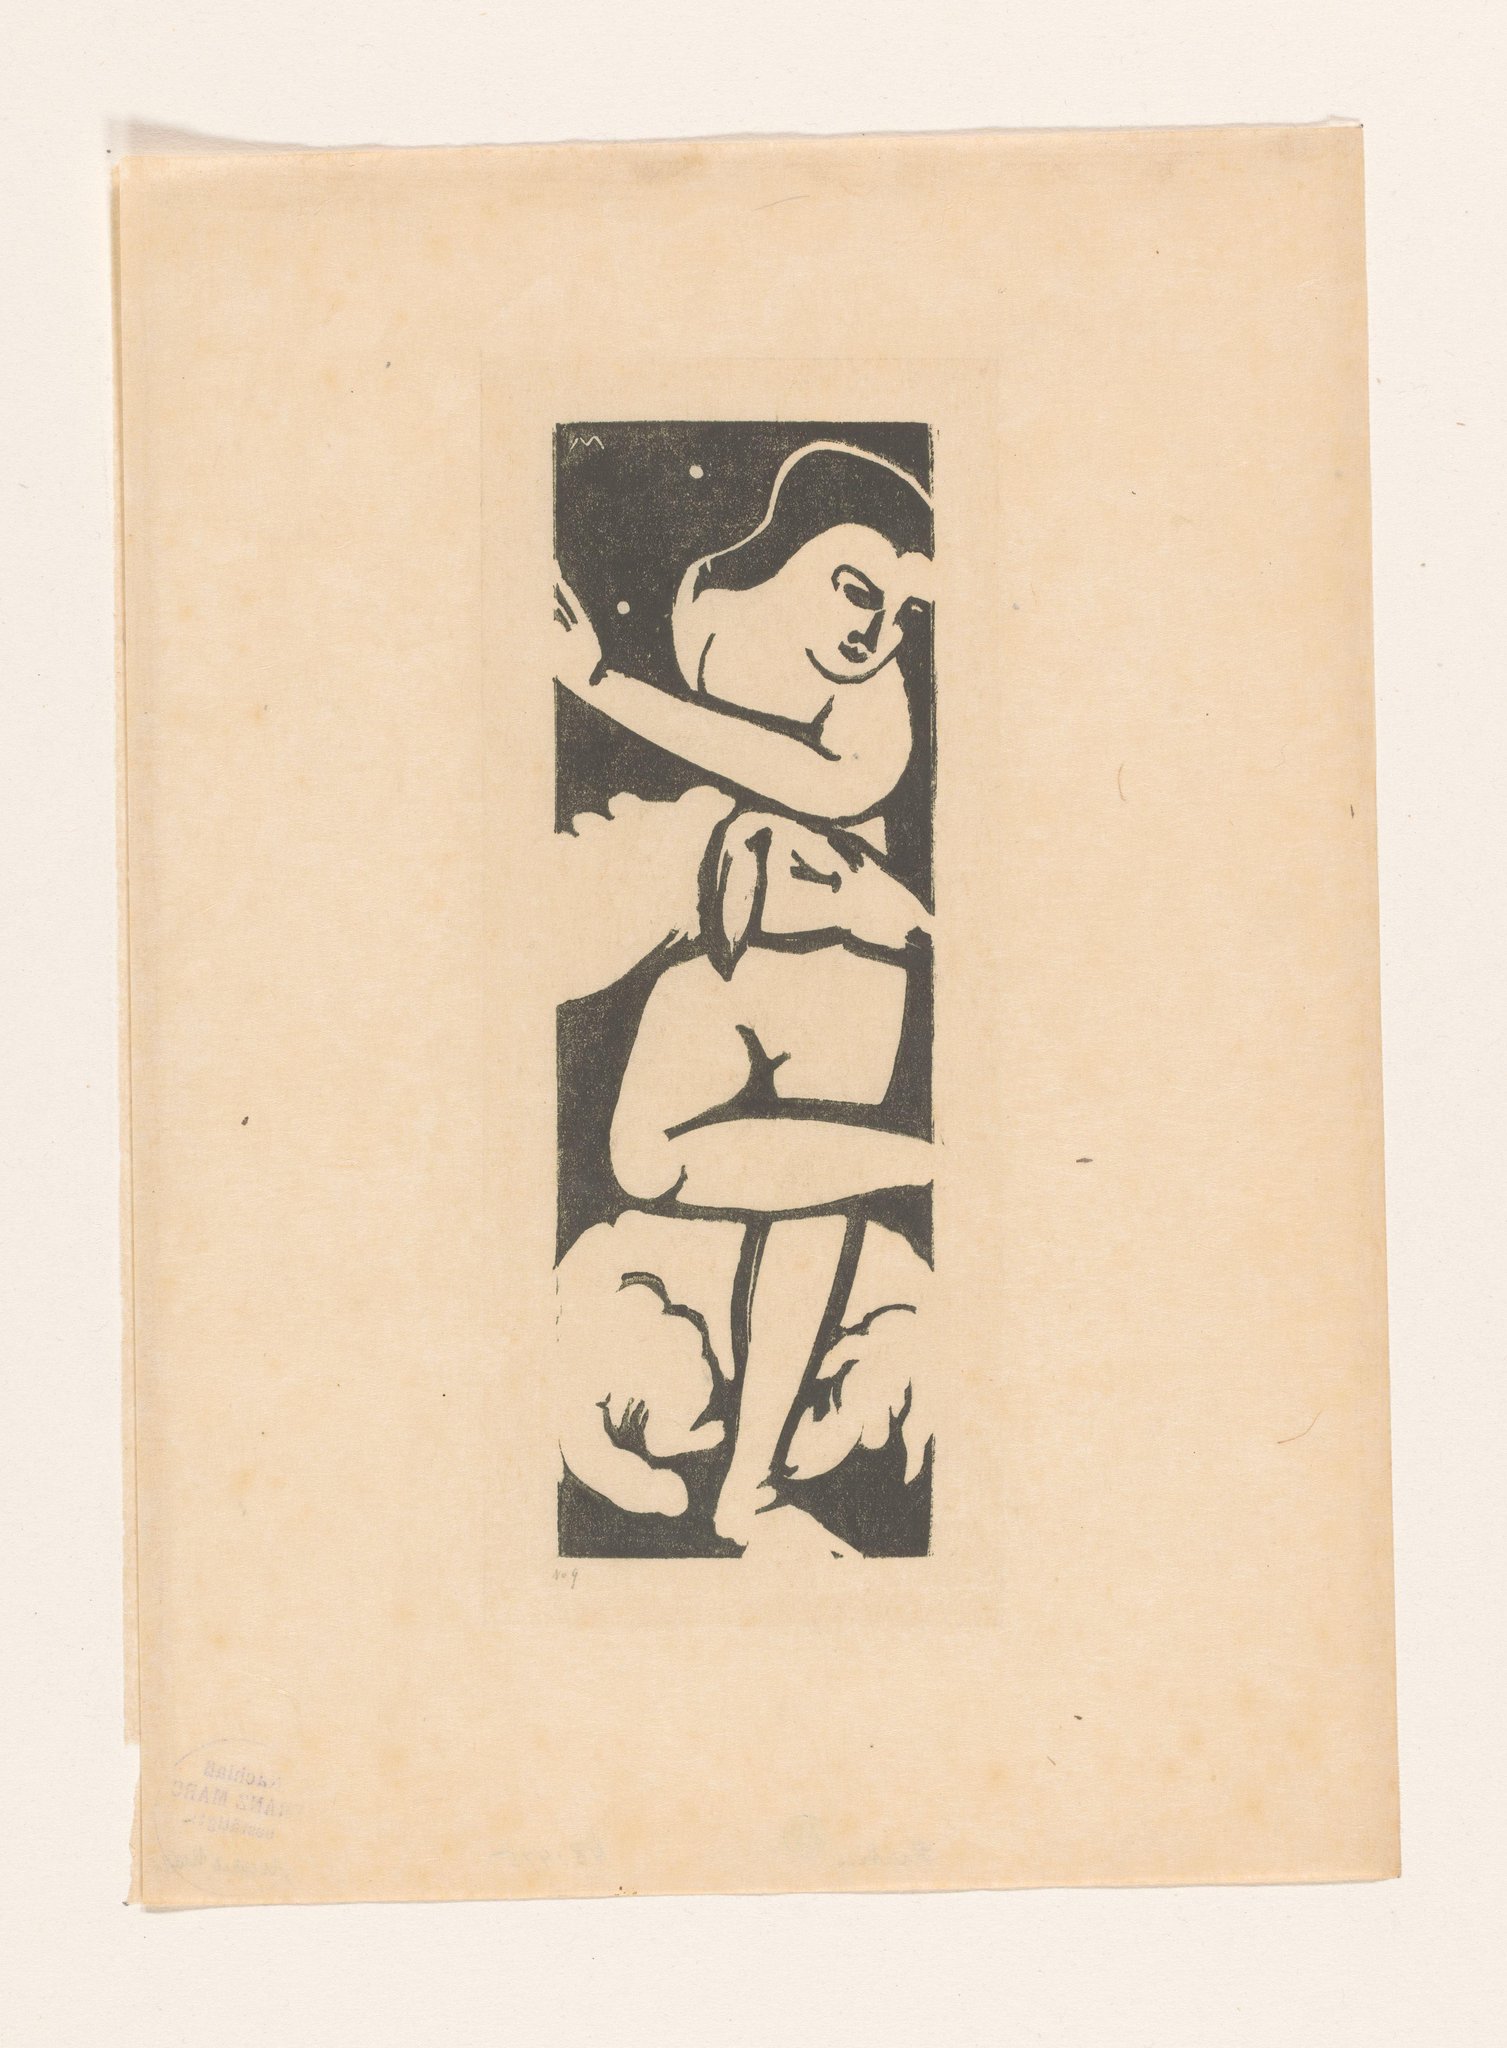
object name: print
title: Vrouw met twee schapen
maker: franz marc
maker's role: print maker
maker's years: 1880-1916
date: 1890-1916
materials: paper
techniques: linocut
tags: herding, herdsman, herdswoman, shepherd, shepherdess, cowherd, etc., sheep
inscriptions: collector's mark: Lugt 733, stamp: ‘Nachlass Franz Marc bestätigt: Maria Marc’